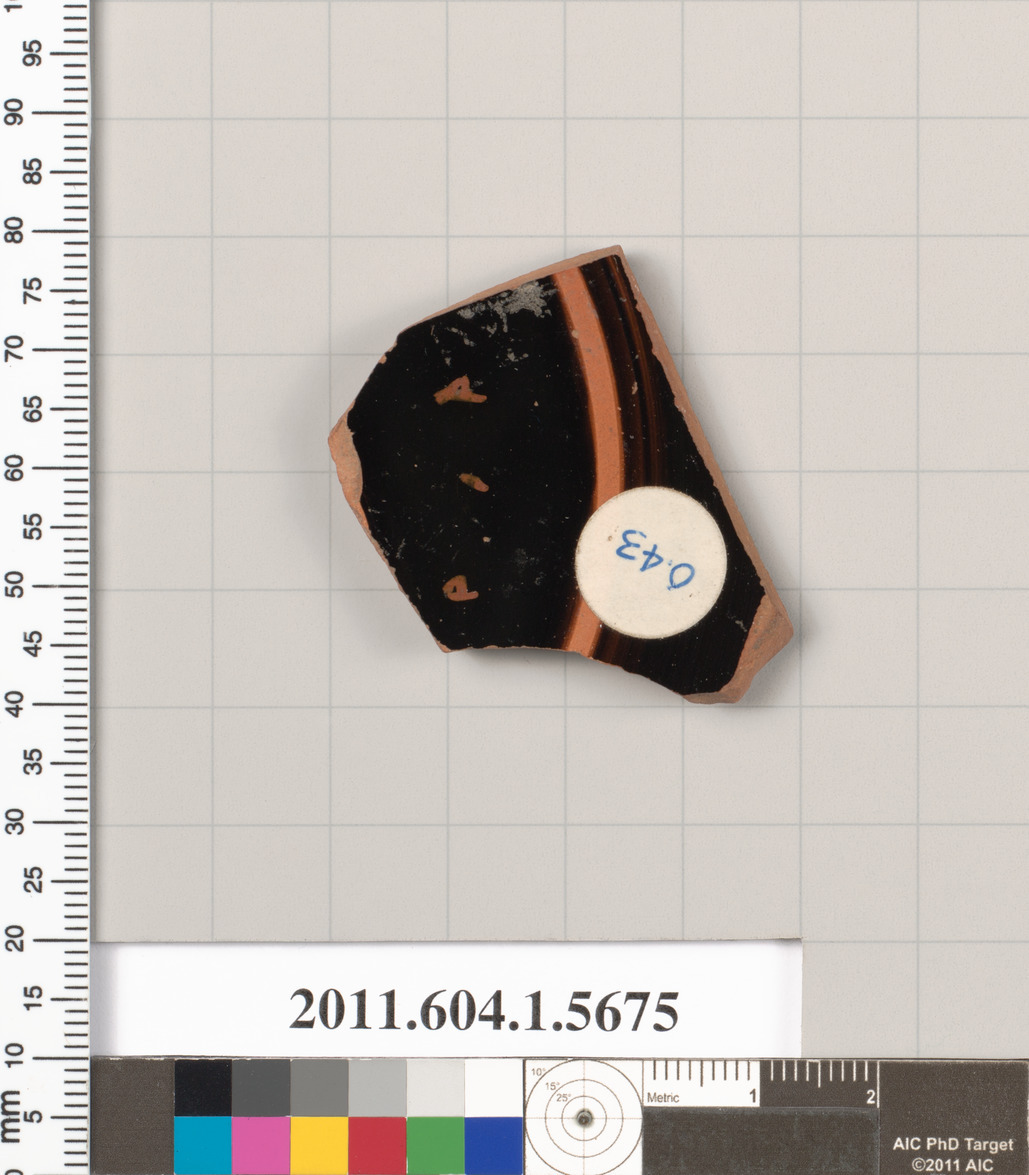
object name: kylix fragment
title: Terracotta fragment of a kylix (drinking cup)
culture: greek, attic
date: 510-480 BCE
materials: terracotta